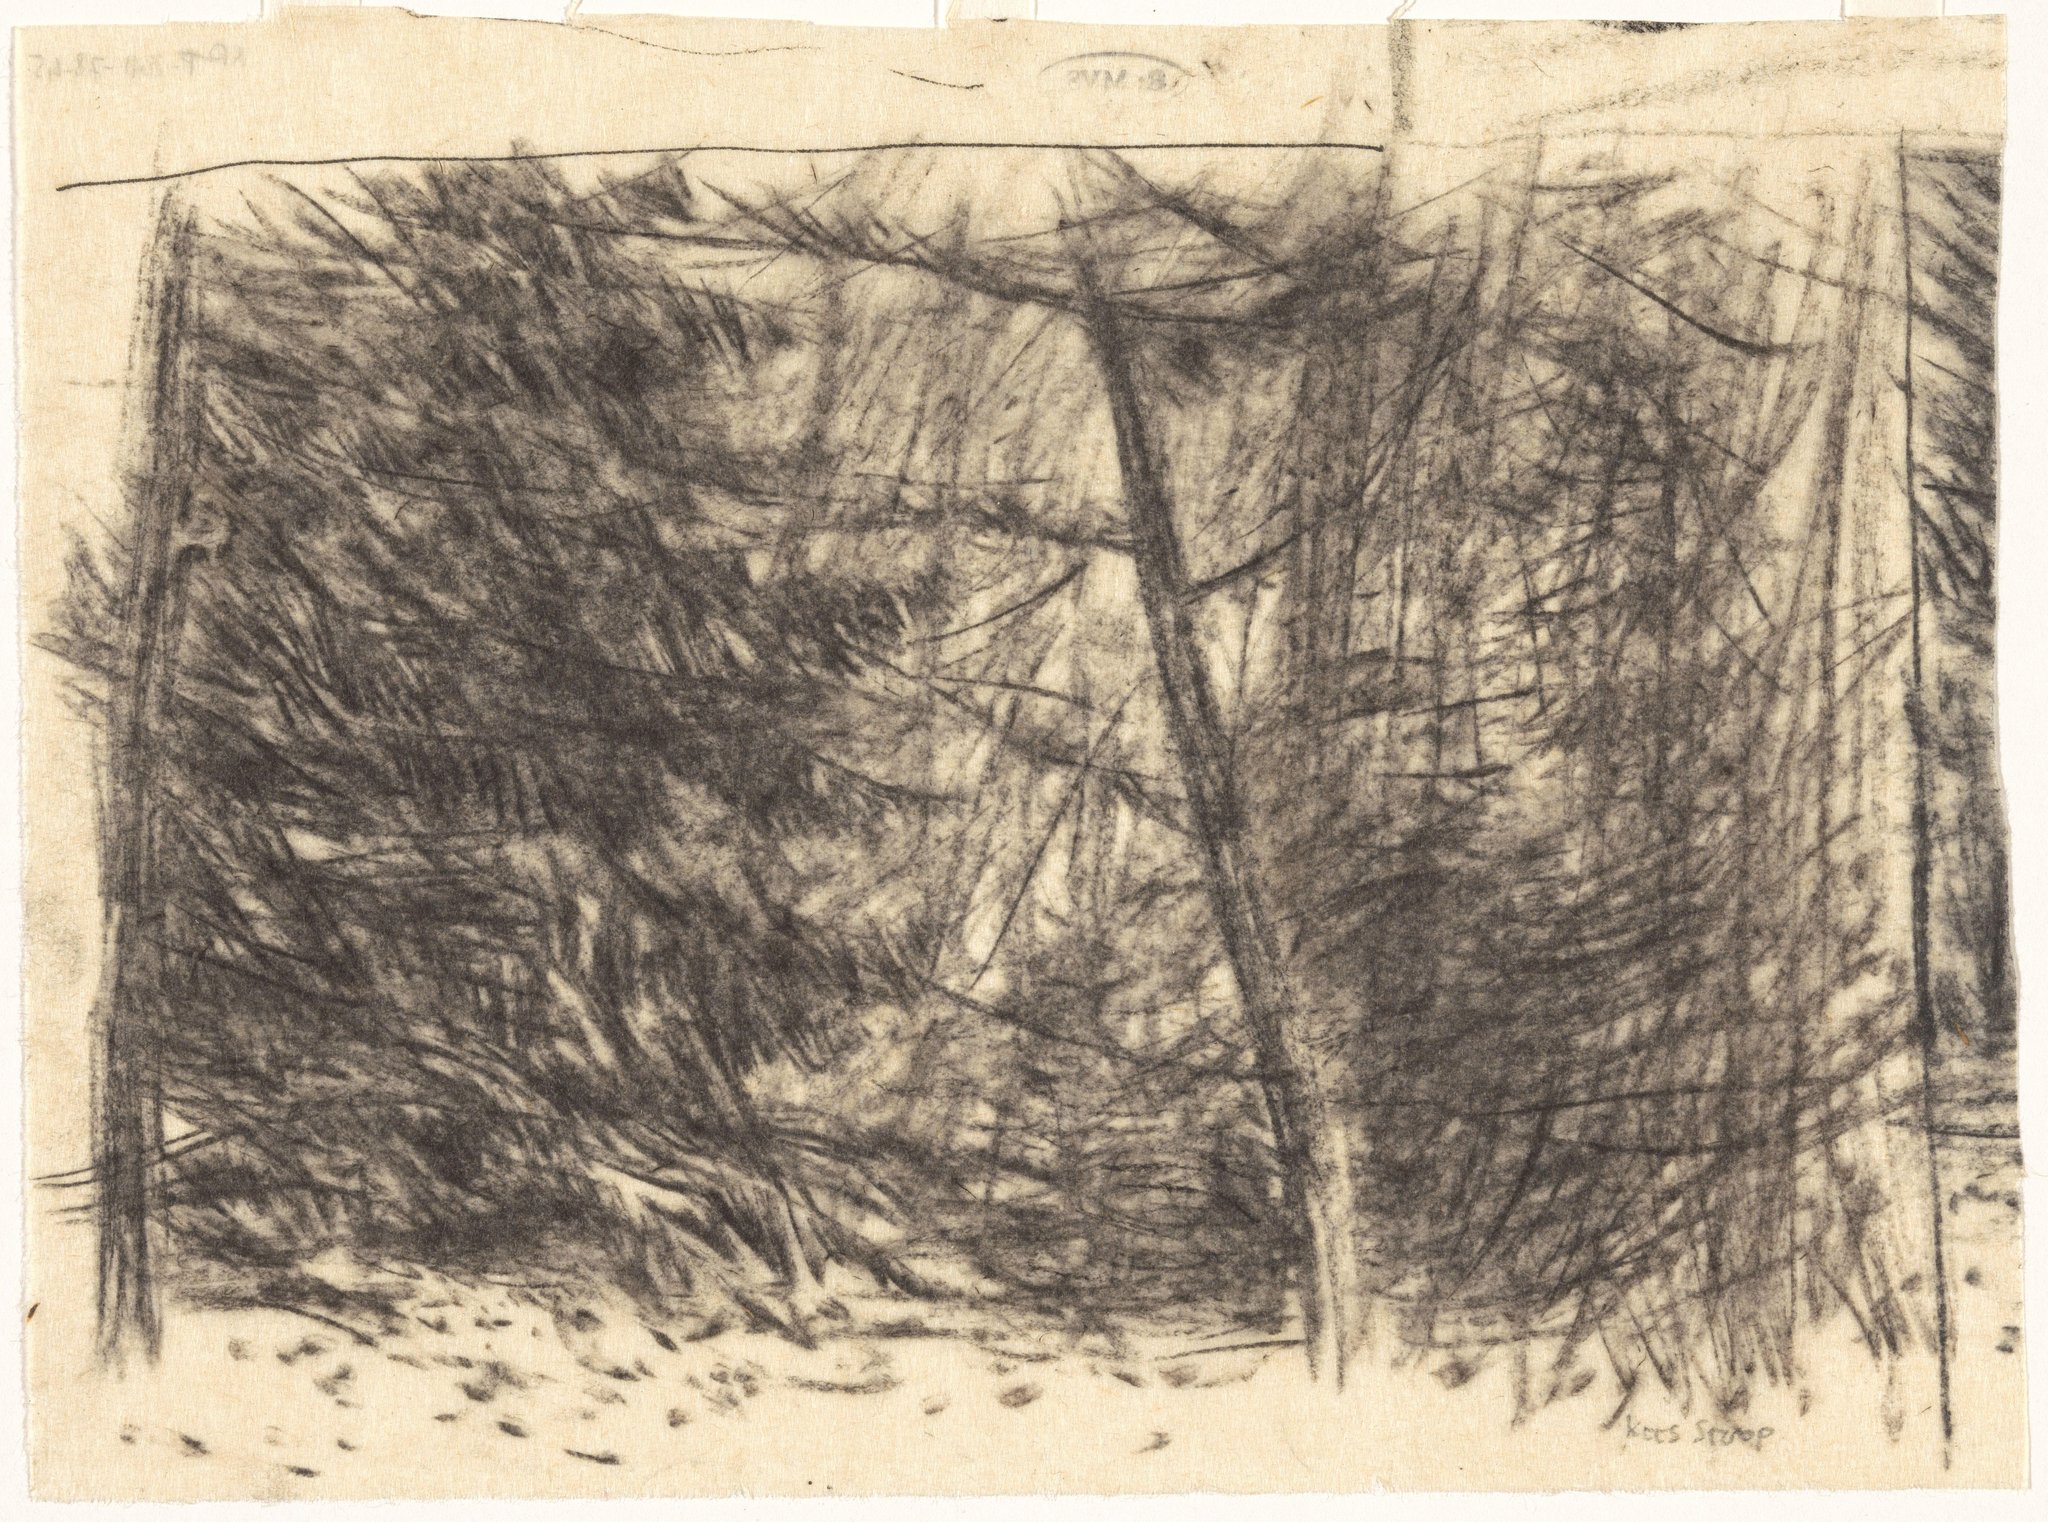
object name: drawing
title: Bomen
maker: kees stoop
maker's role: draughtsman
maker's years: 1929-2019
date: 1939-2009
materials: charcoal, paper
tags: forest, wood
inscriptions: signature: ‘Kees Stoop’